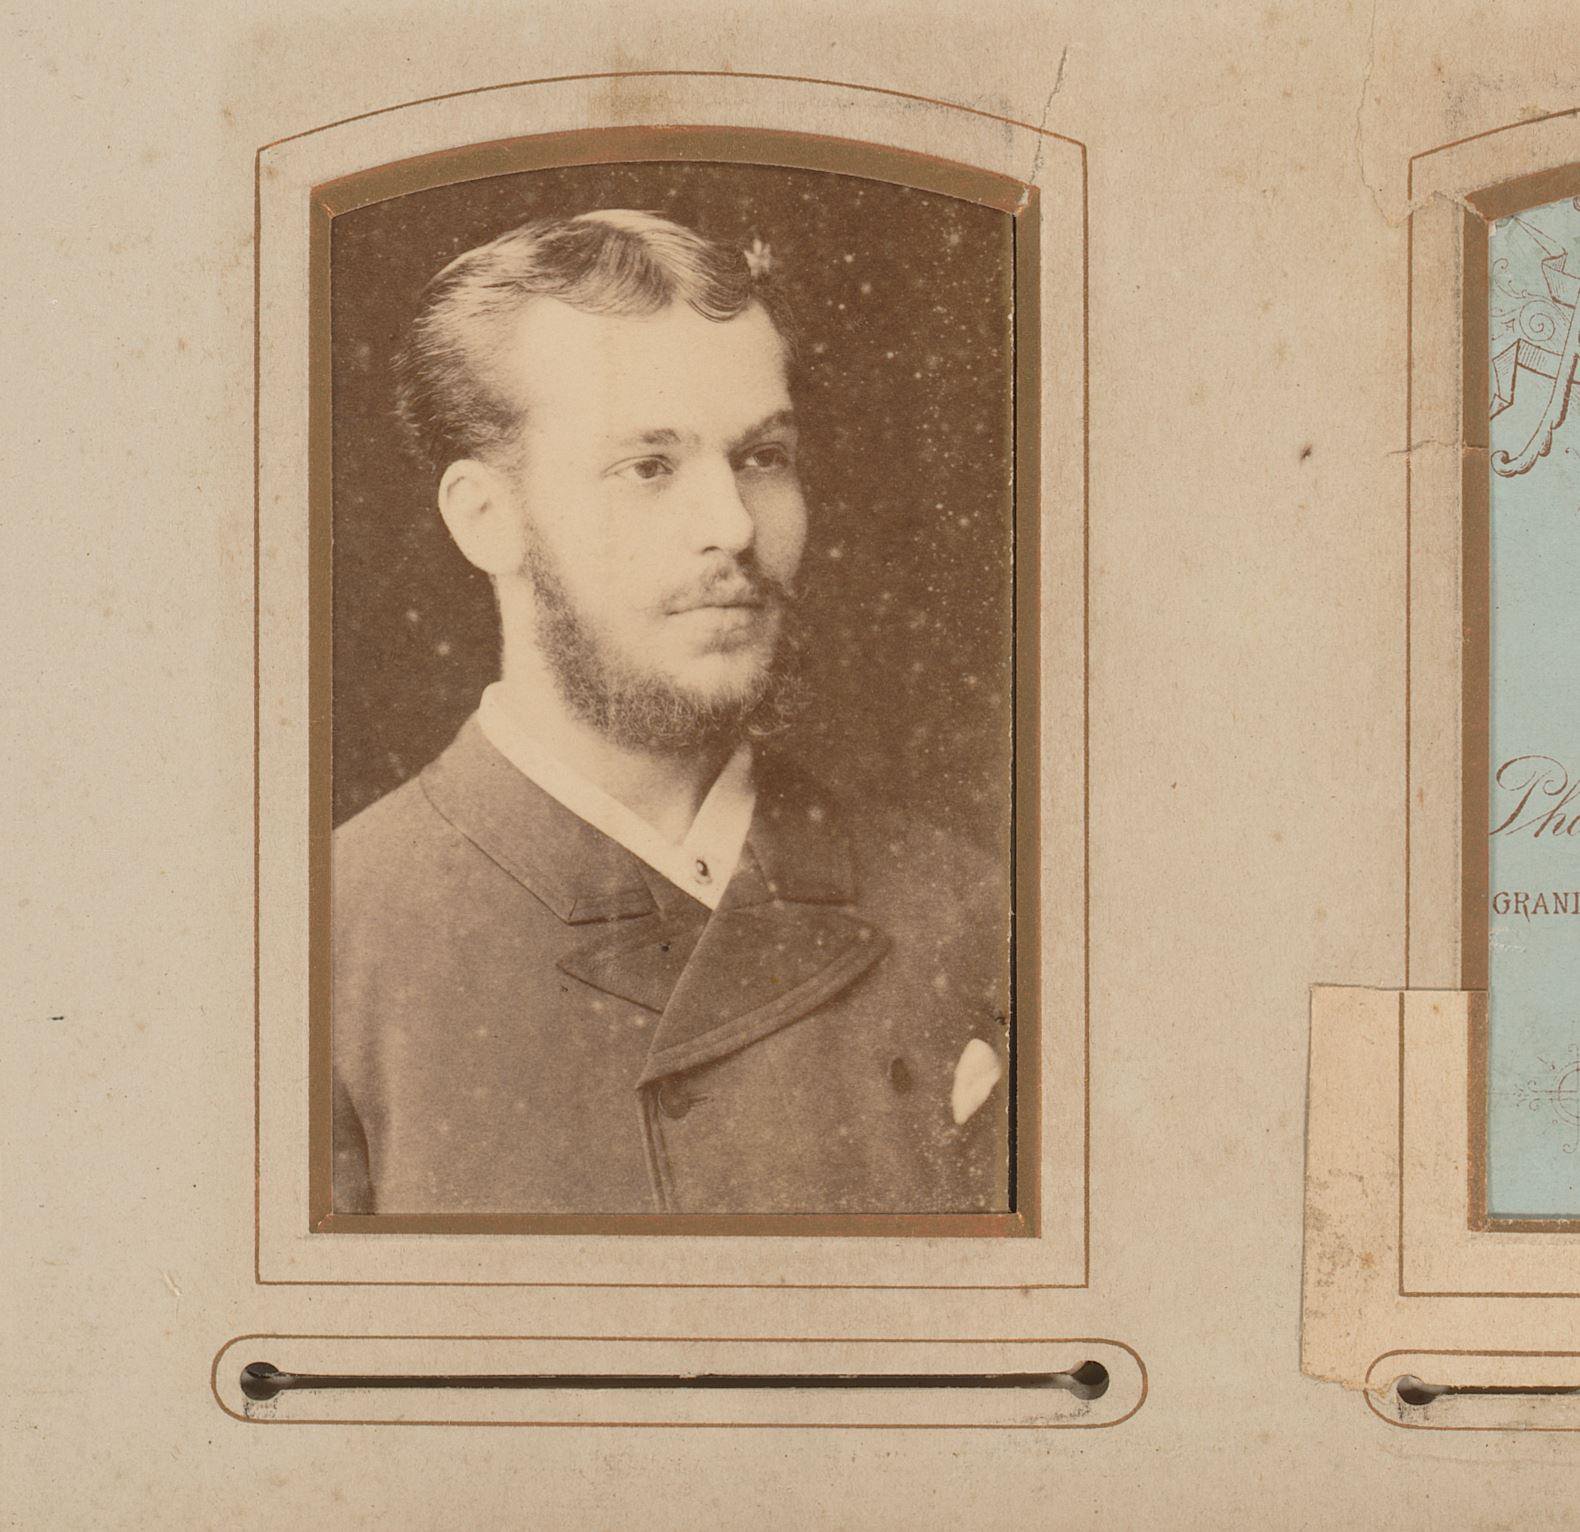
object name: album leaf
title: Portret van een man met baard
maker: herman salzwedel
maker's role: fotograaf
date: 1880-1905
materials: cardboard, photographic support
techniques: albumen print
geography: surabaya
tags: historical persons, beard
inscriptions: inscription: ‘(...)/ ATELIER/ van/ H. SALZWEDEL/ SOERABAYA/ JAVA.’